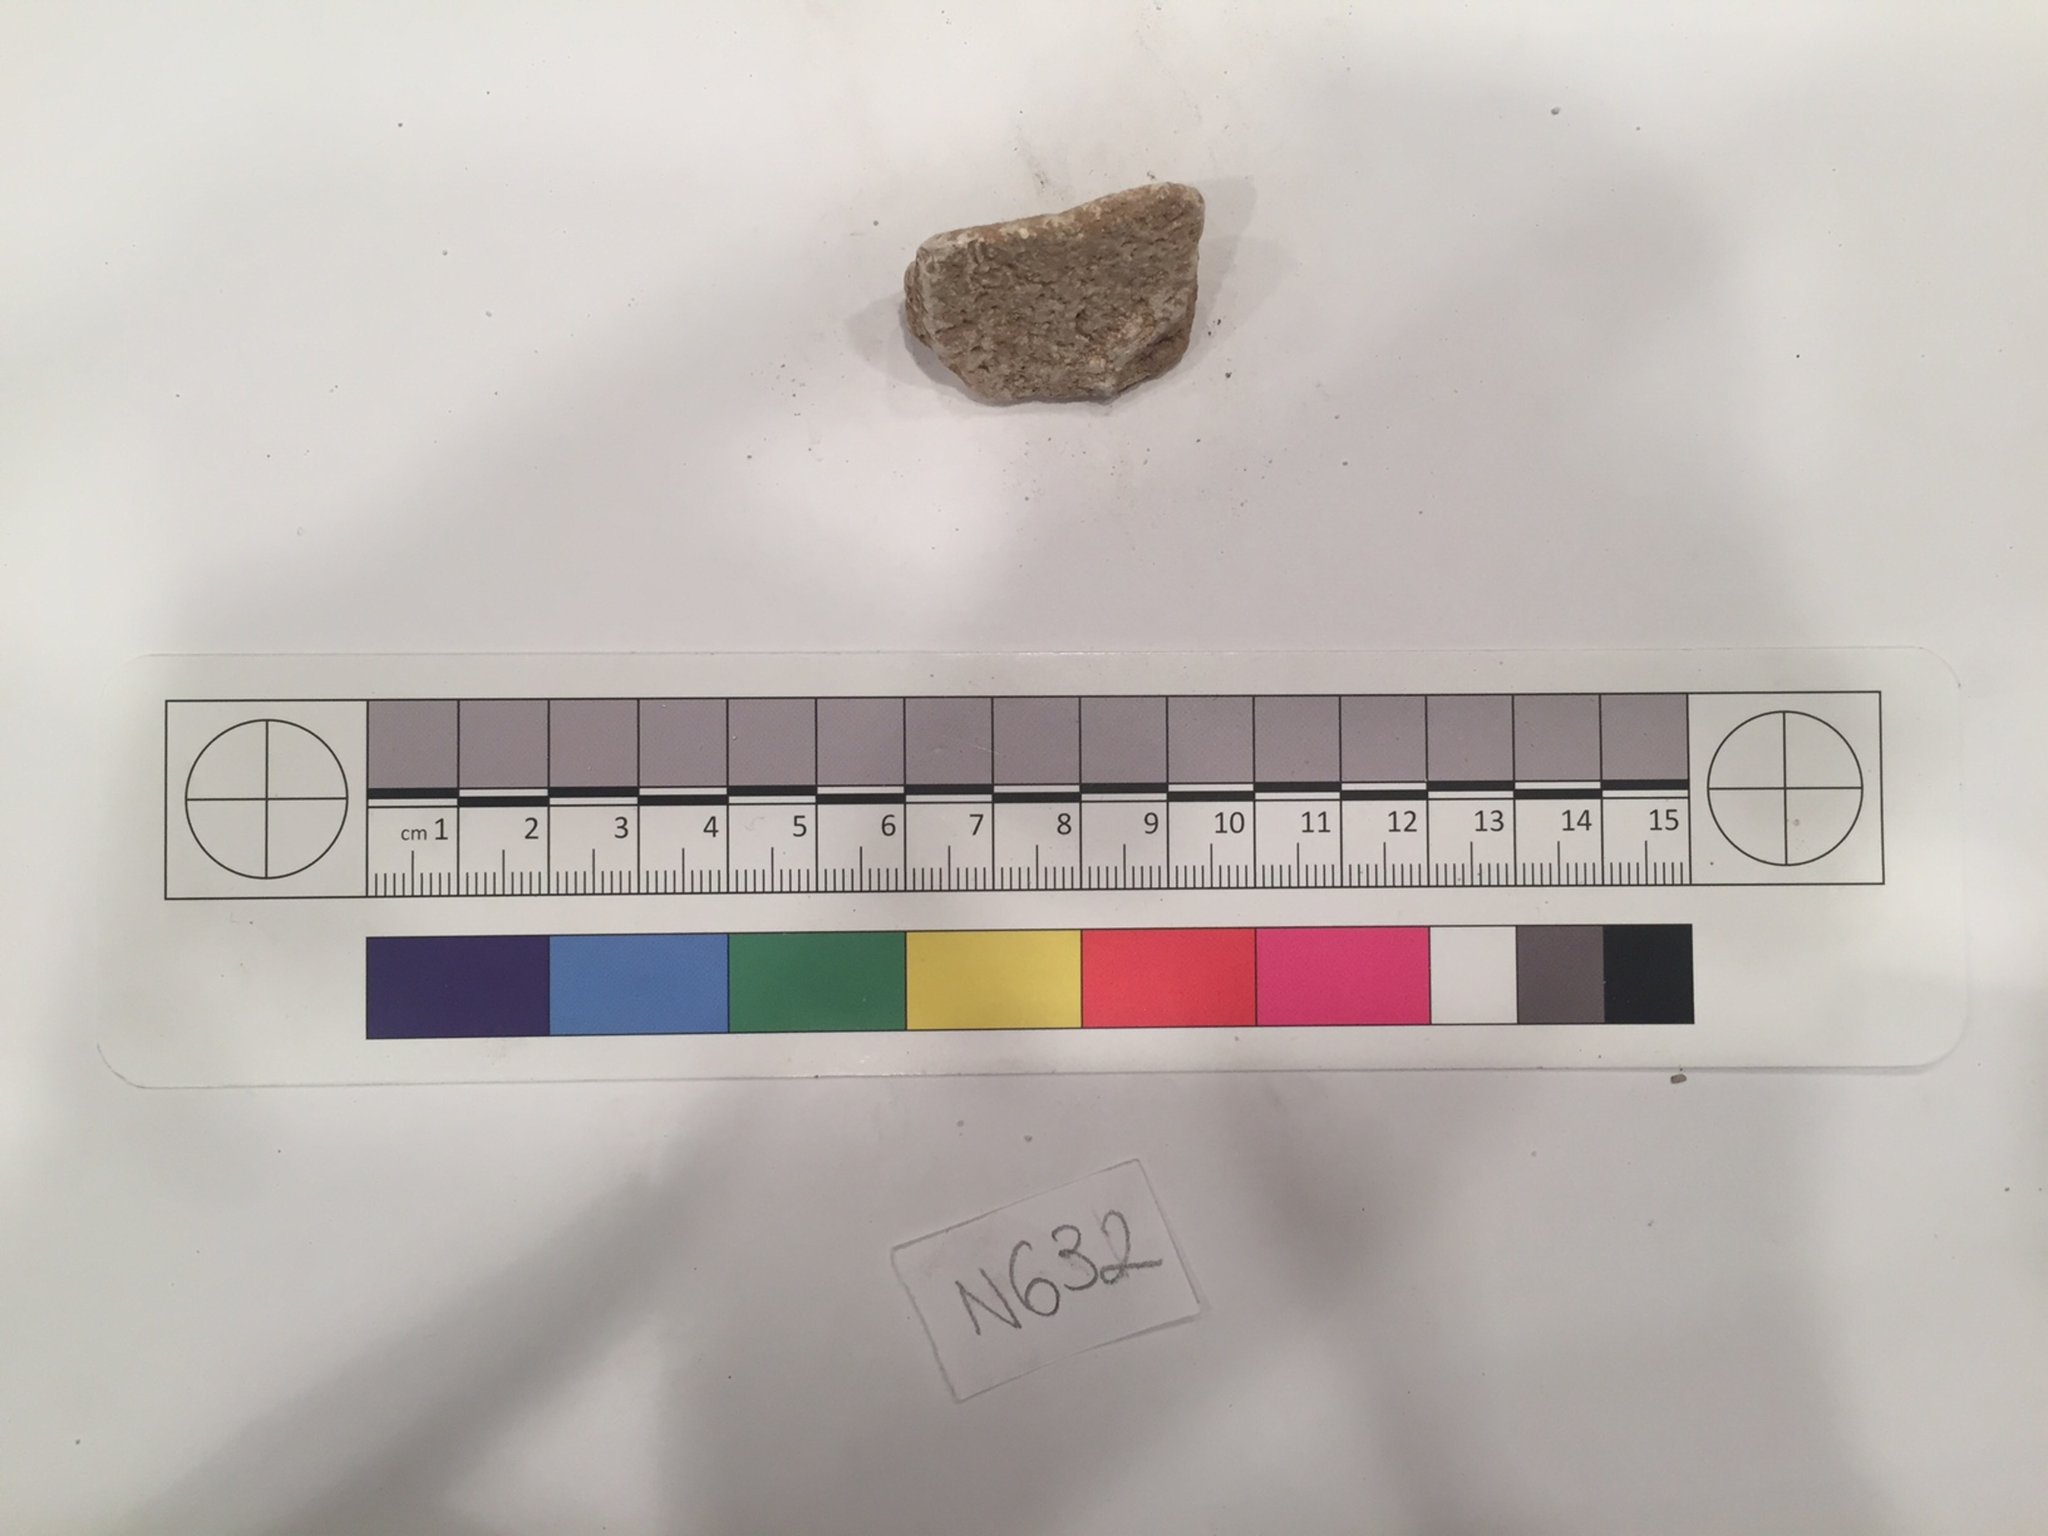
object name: fragment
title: Stucco Fragment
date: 701-1200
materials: plaster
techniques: carving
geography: iran